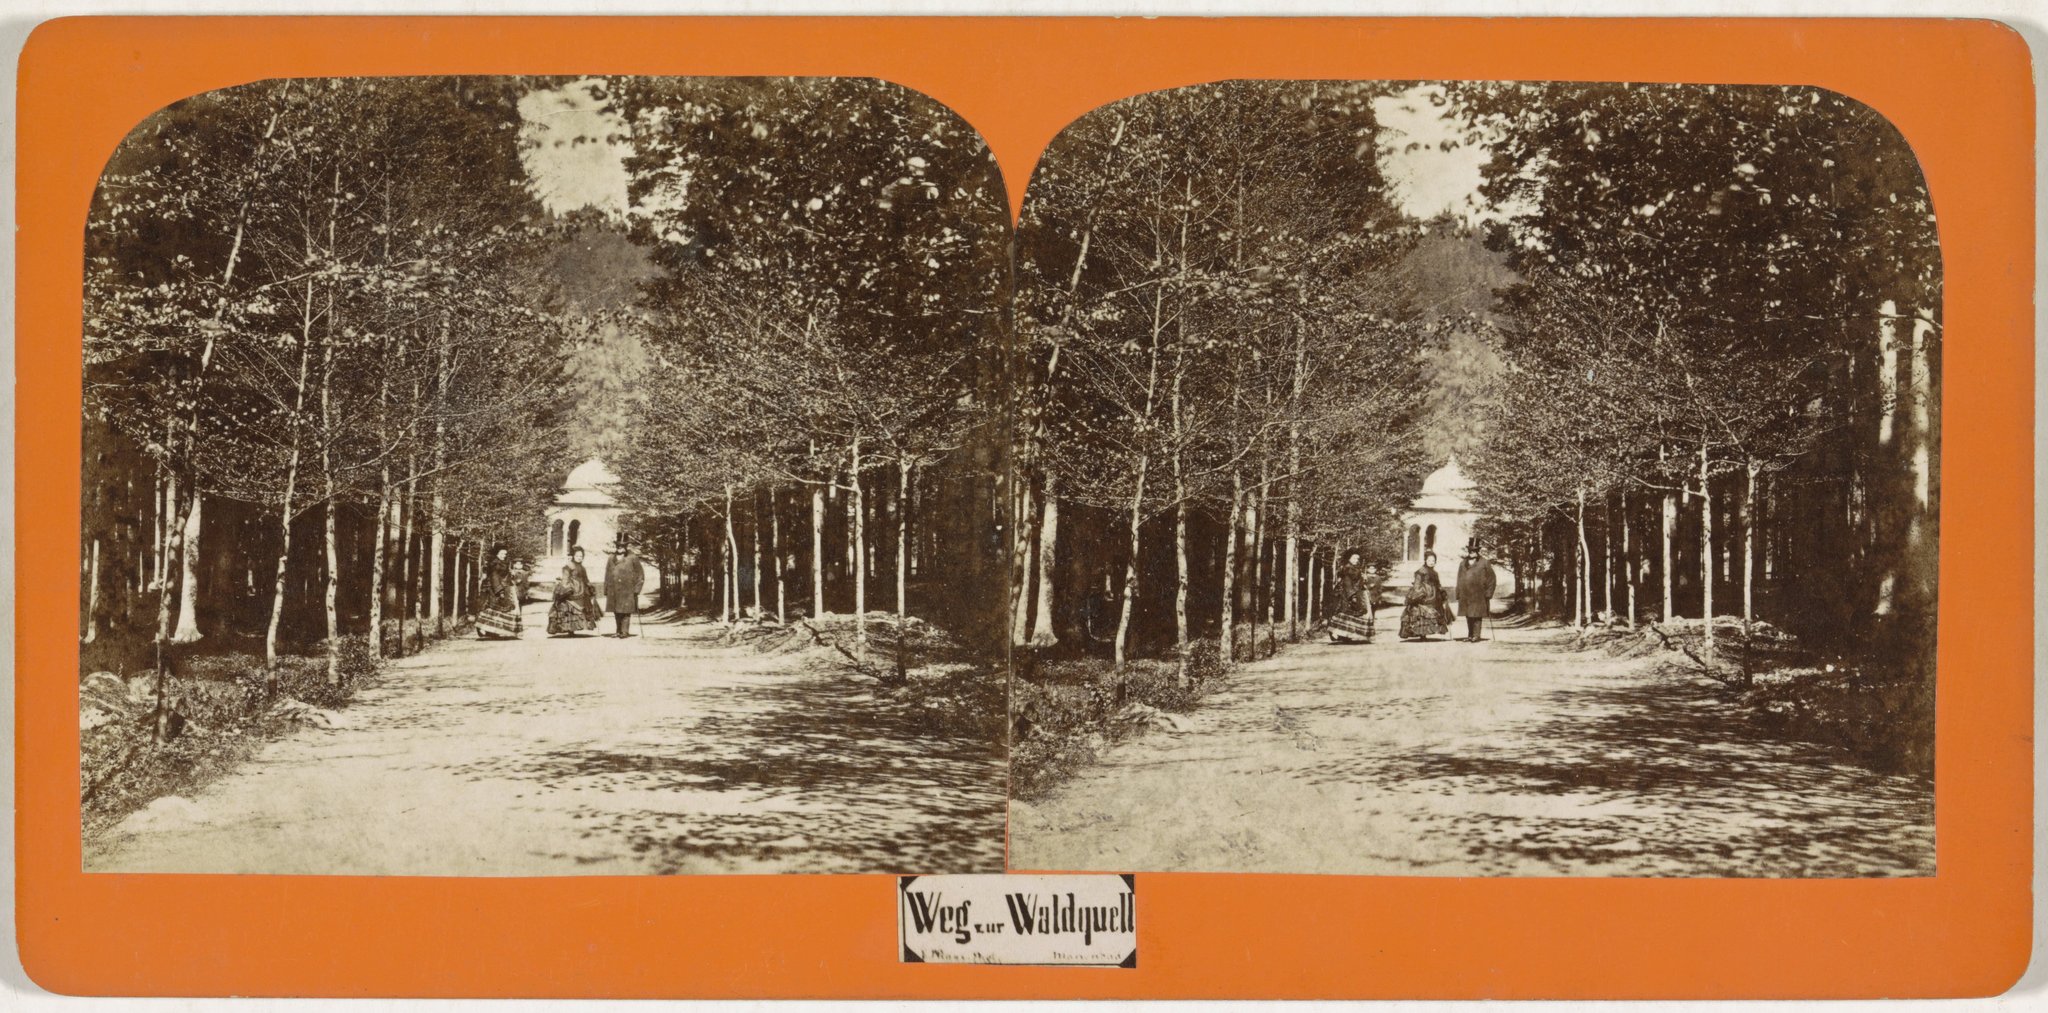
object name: stereograph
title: Weg zur Waldquell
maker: ernst pflanz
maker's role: painter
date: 1865-1885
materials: cardboard, paper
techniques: albumen print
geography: marienbad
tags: forest path or lane, marienbad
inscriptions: inscription: ‘Marienbad’